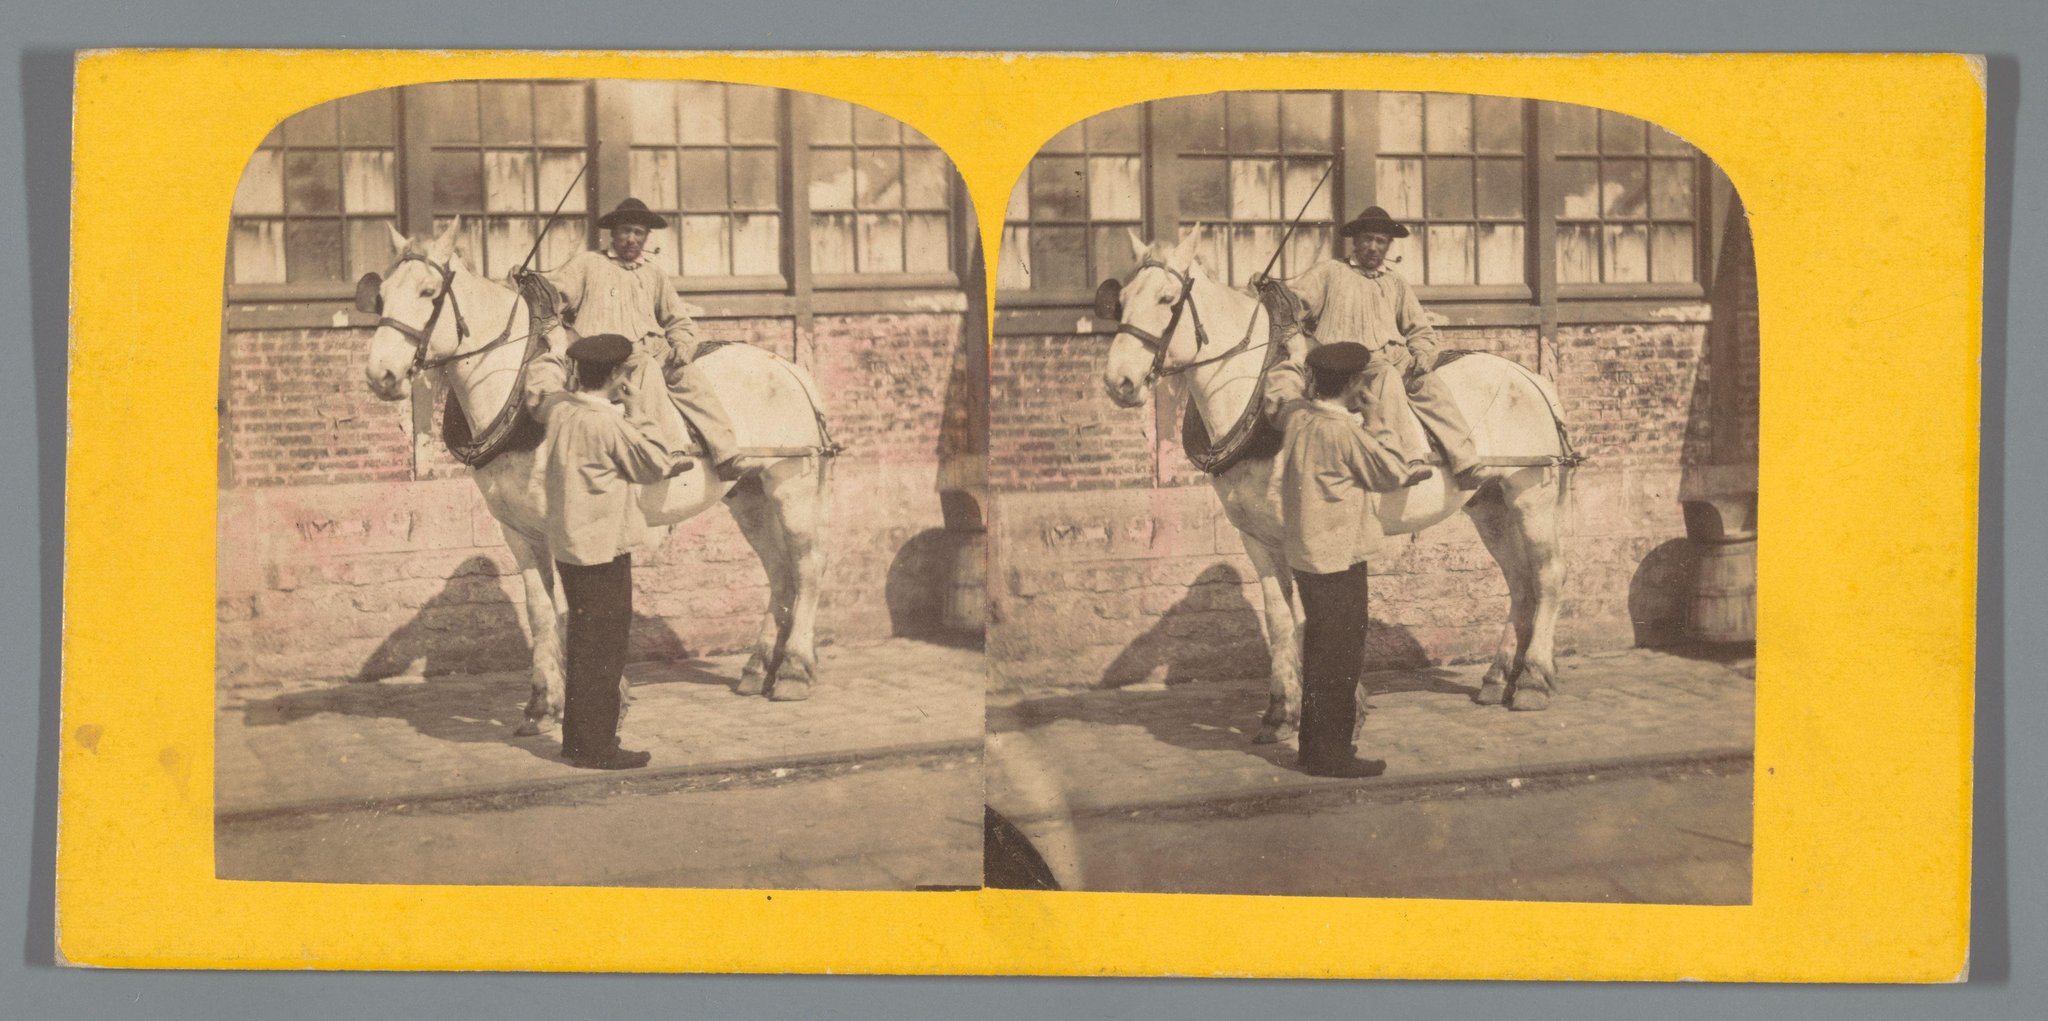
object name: stereograph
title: Man zit zijwaards op een wit paard terwijl een andere man de teugels vasthoudt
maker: Anonymous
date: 1858-1870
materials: cardboard, paper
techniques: albumen print, hand coloring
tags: riding a horse, ass, or mule; rider, horseman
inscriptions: inscription: ‘[...]’, inscription: ‘44.’, inscription: ‘3041. n/’